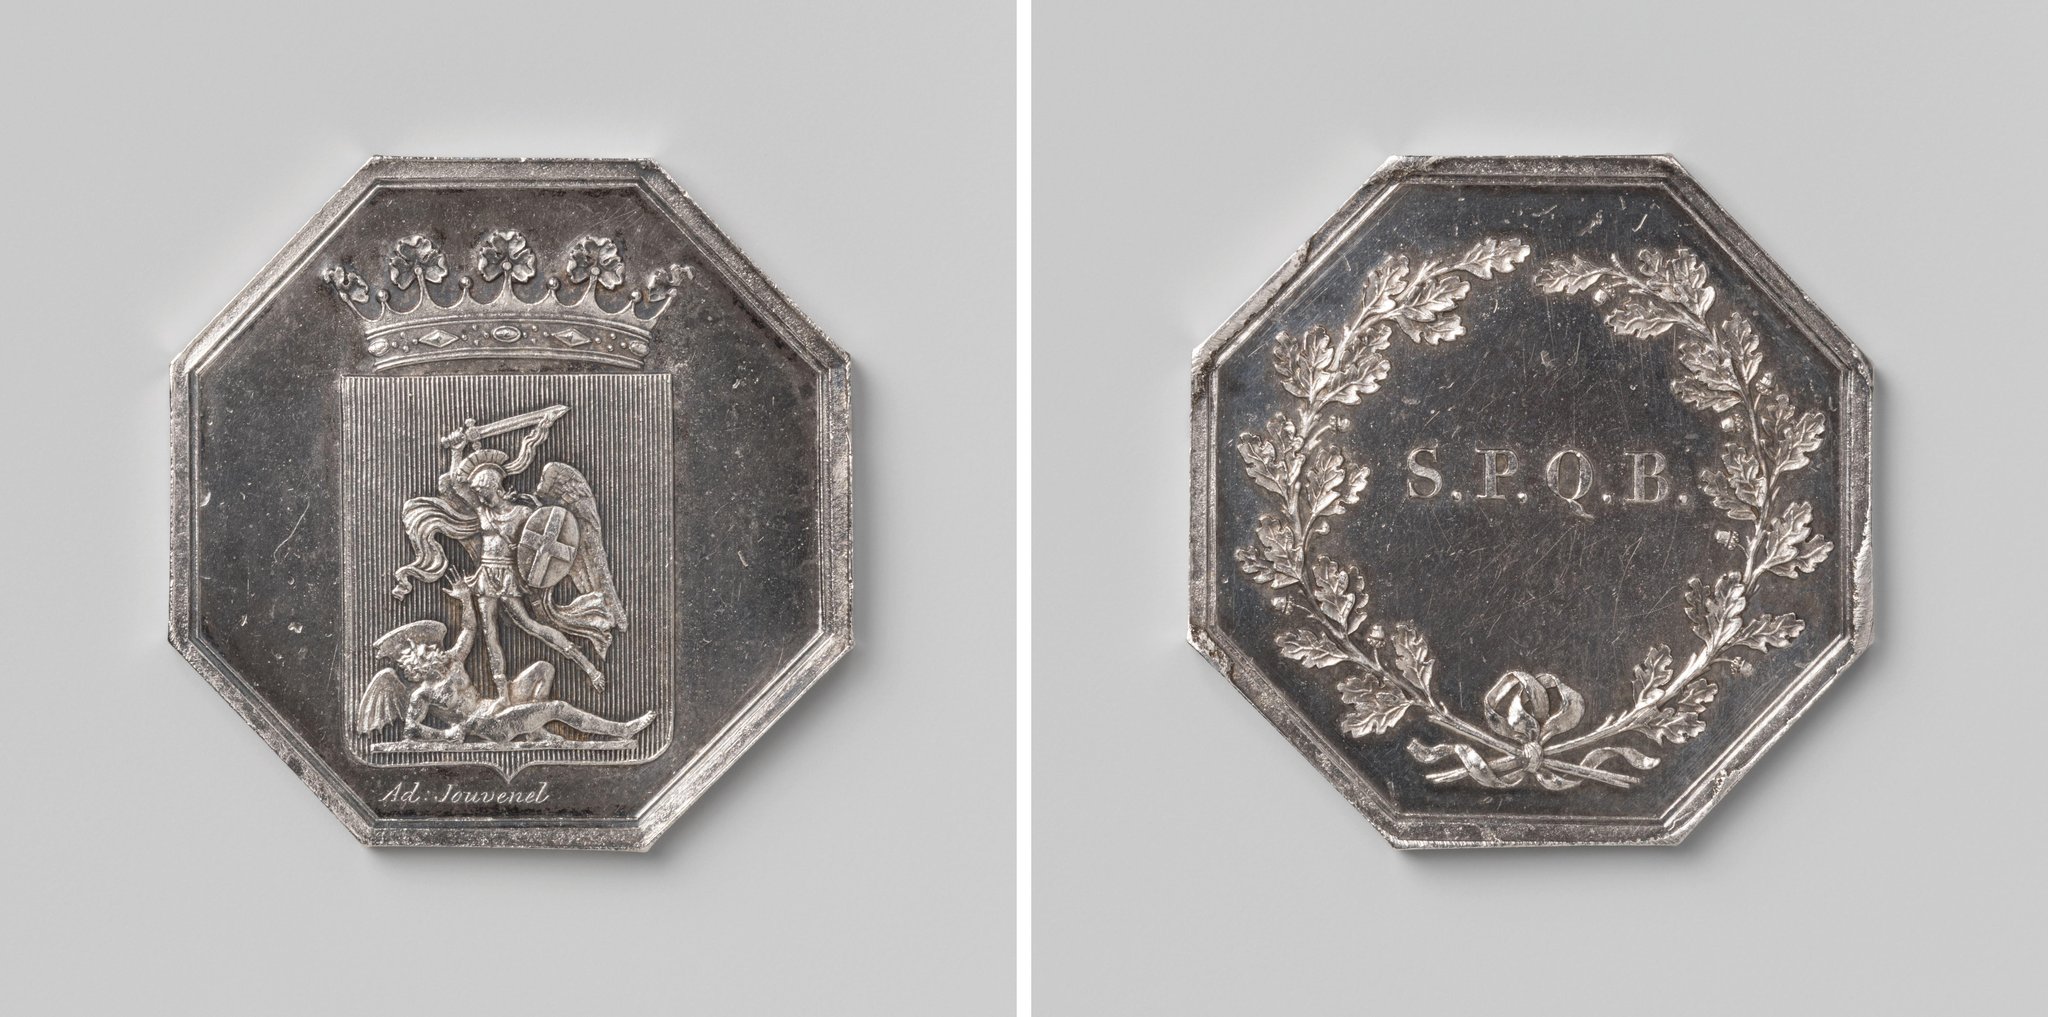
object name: raadspenning, raadsteken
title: Raadspenning van de stad Brussel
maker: adolphe jouvenel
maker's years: 1798-1867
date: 1818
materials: silver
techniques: striking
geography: brussels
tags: brussels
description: achthoekige penning. Voorzijde: gekroond wapenschild boven signatuur. Keerzijde: monogram van letters S, P, Q en B binnen eikekrans